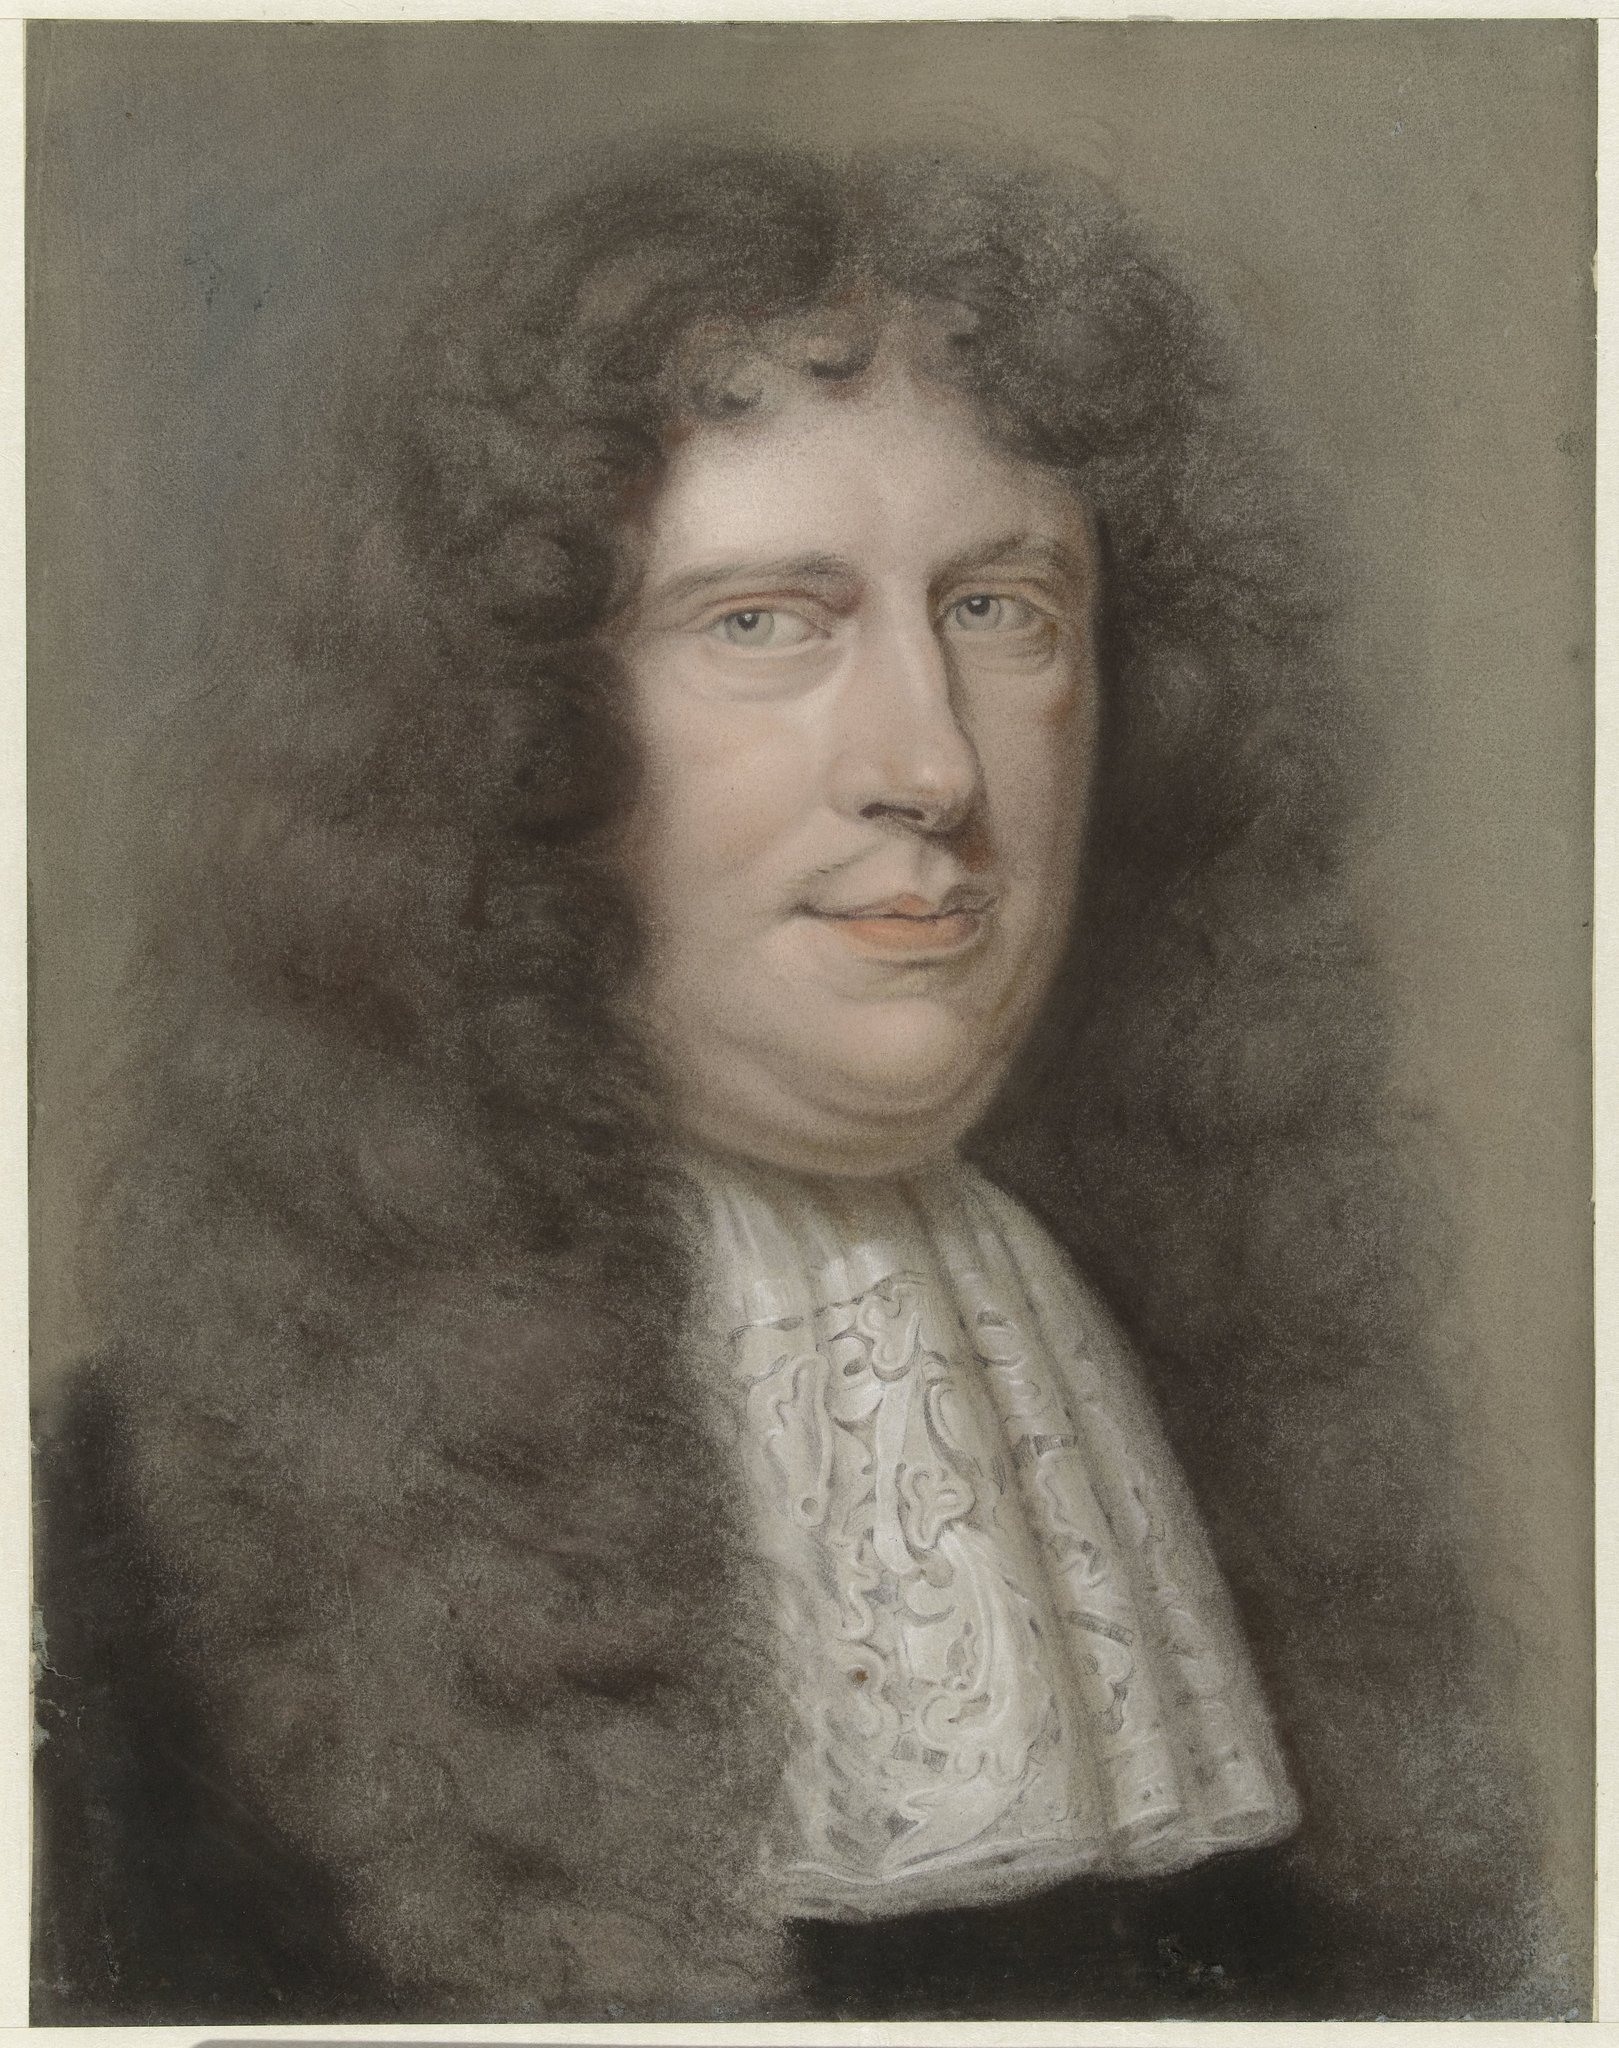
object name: drawing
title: Portret van Graaf Theodor Alethaeus Heinrich Strattmann, gezant te Nijmegen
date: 1633-1693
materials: paper, pastel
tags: historical persons